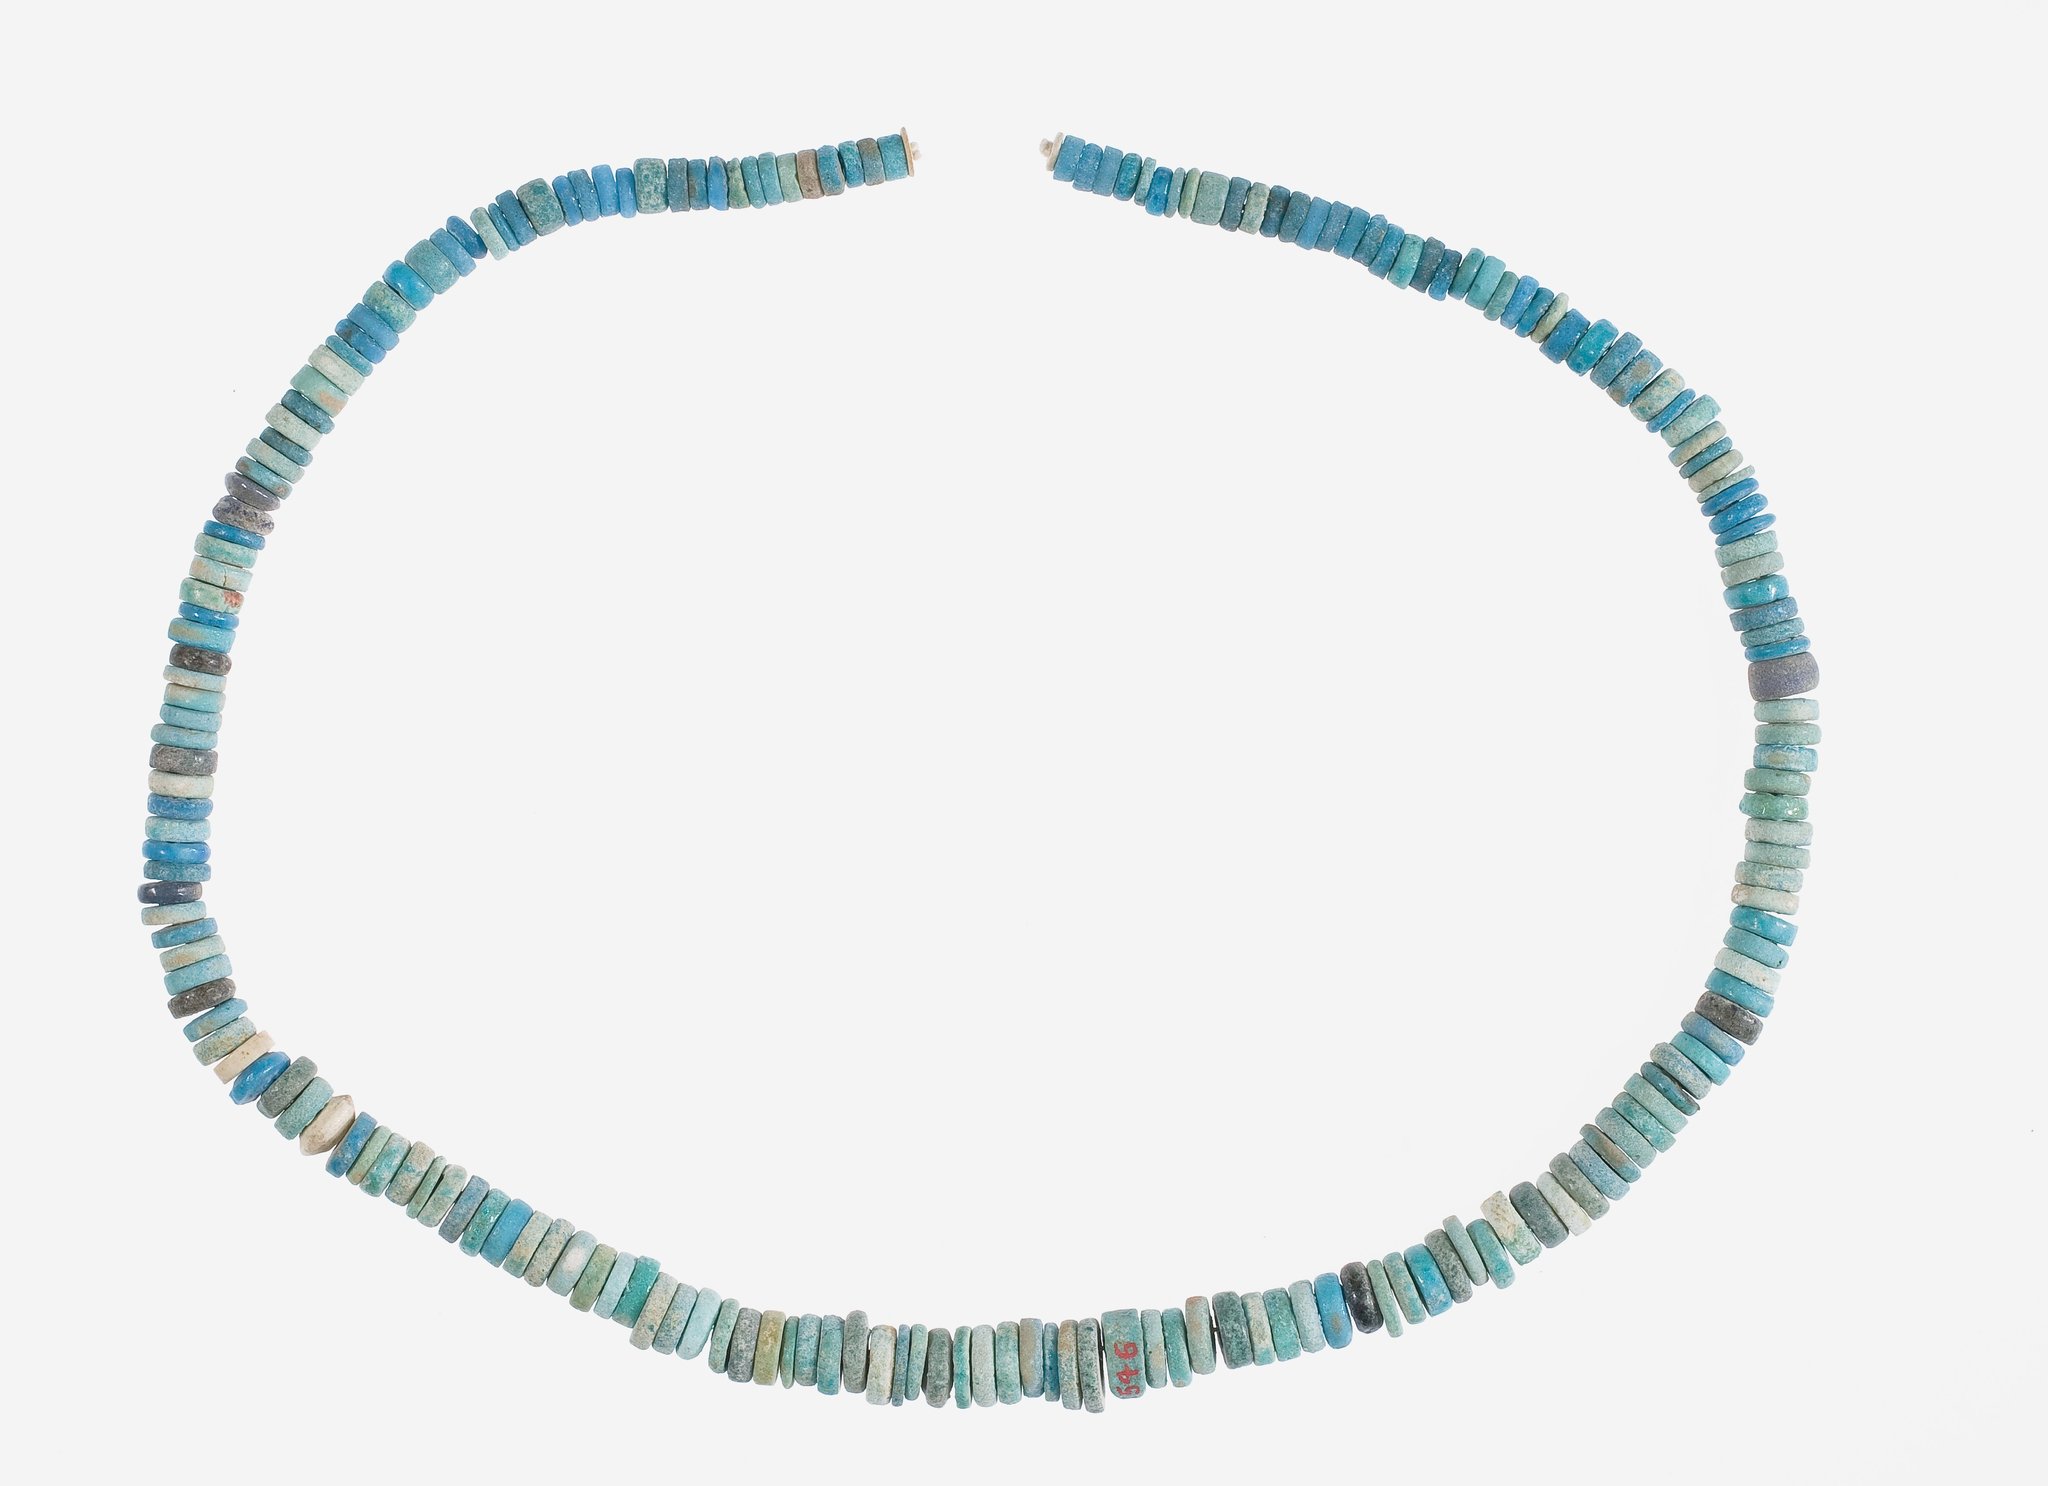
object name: bead, disk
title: String of Small Disk Beads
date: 1390-1352 BCE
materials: faience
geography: egypt